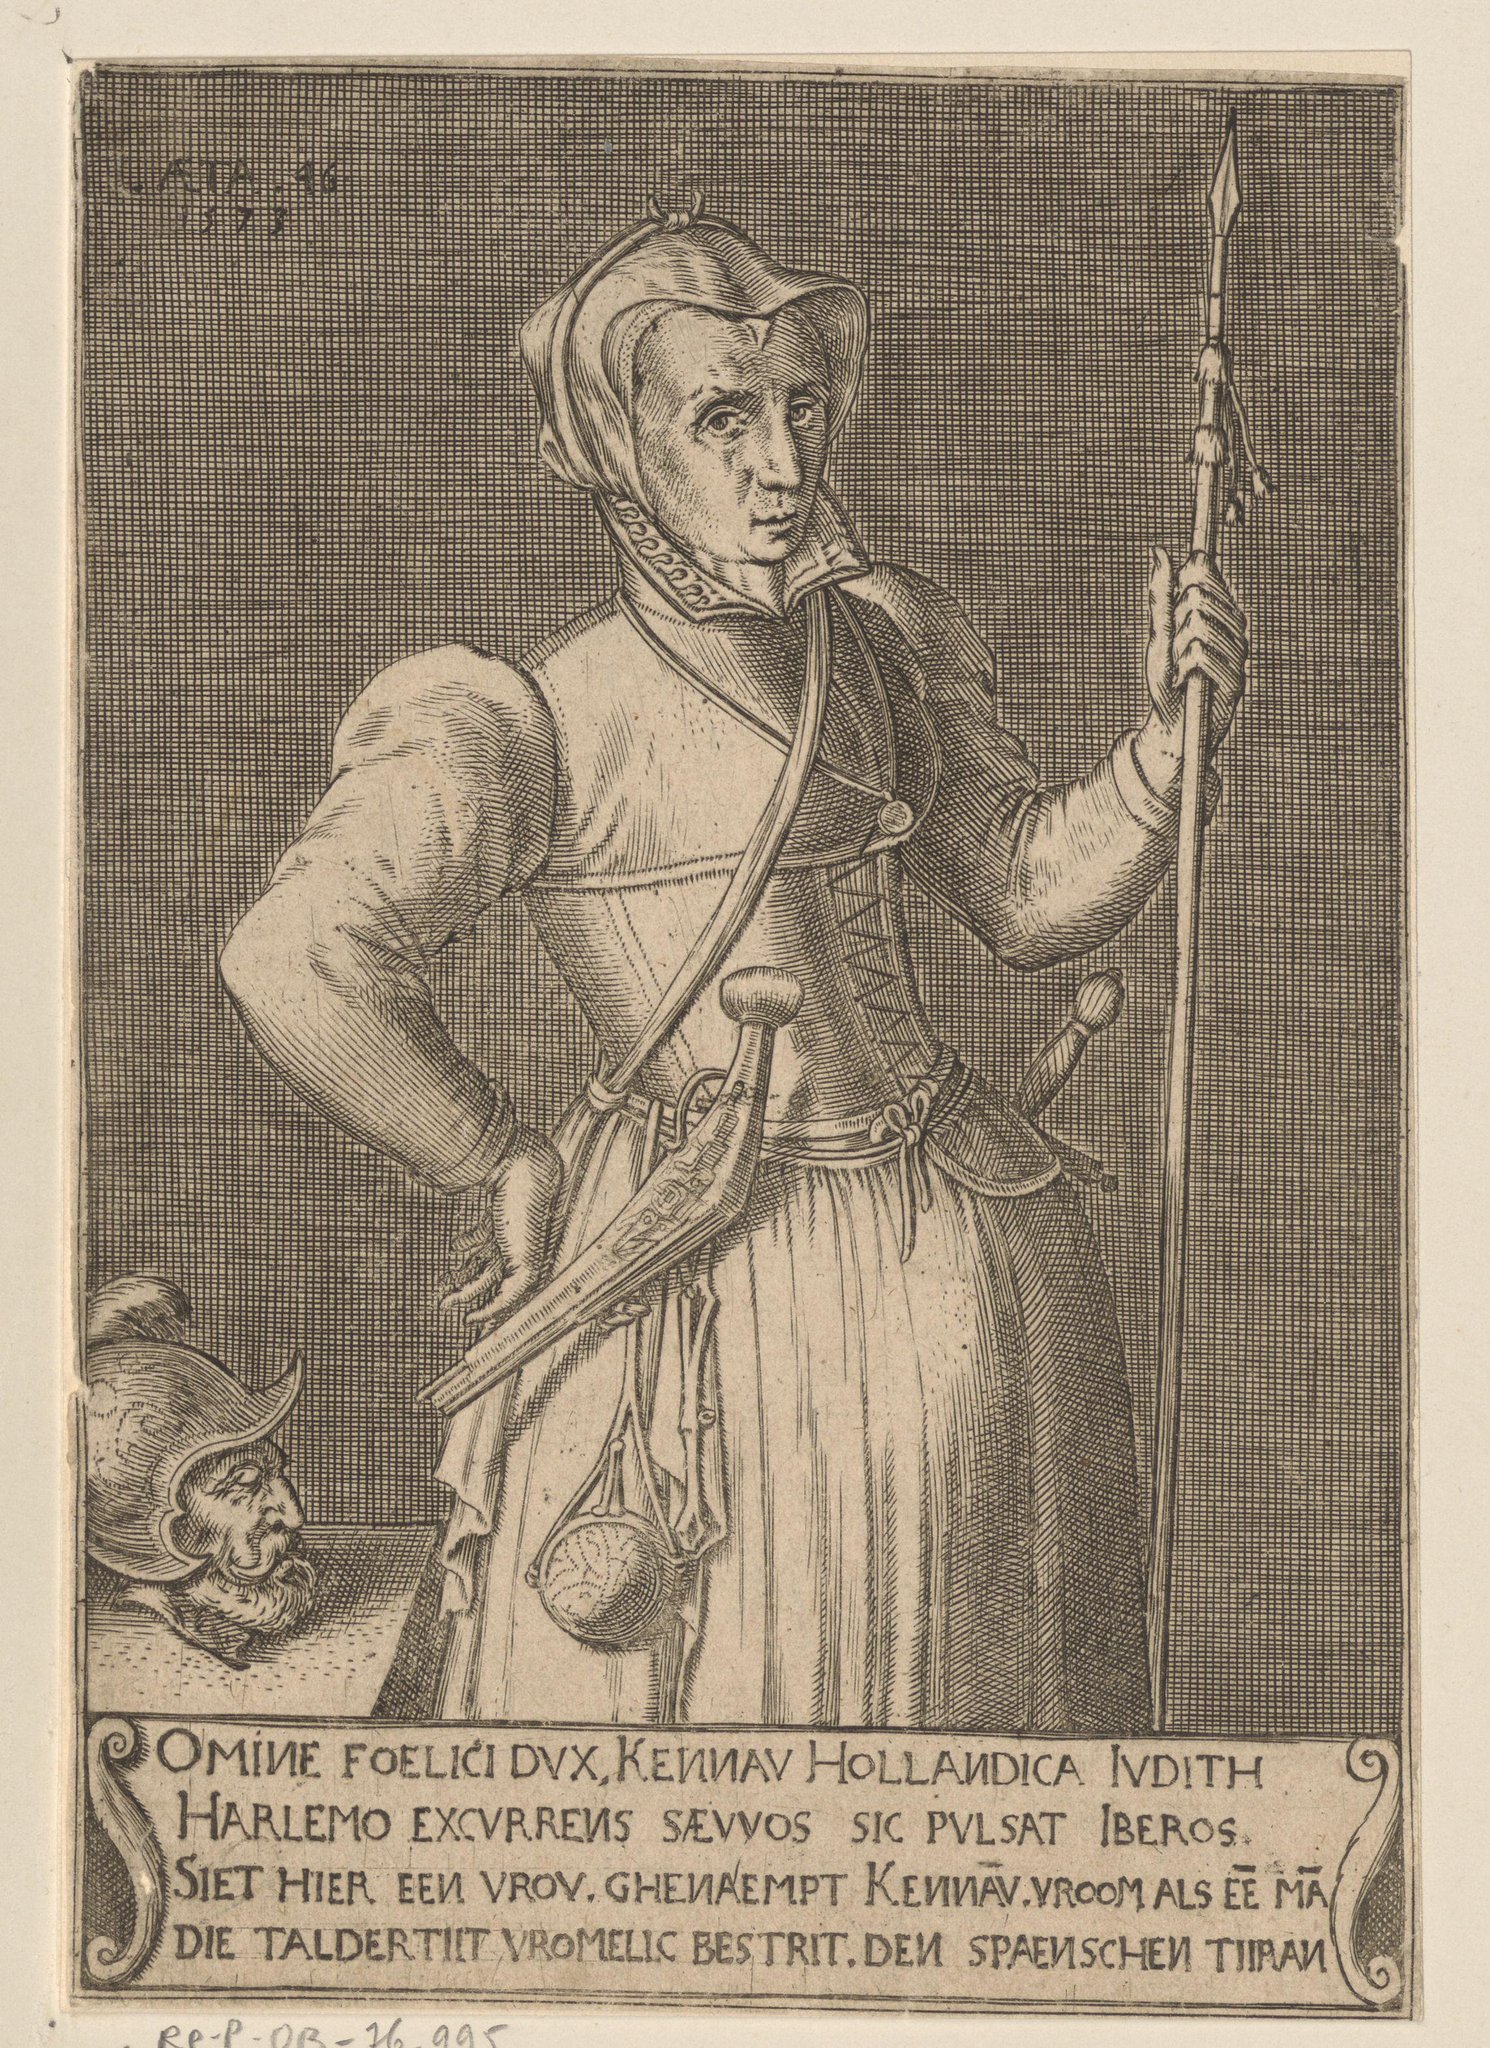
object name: print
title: Portret van Kenau Simonsdochter Hasselaer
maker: Anonymous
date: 1600-1649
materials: paper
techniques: engraving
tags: historical persons - bb - woman